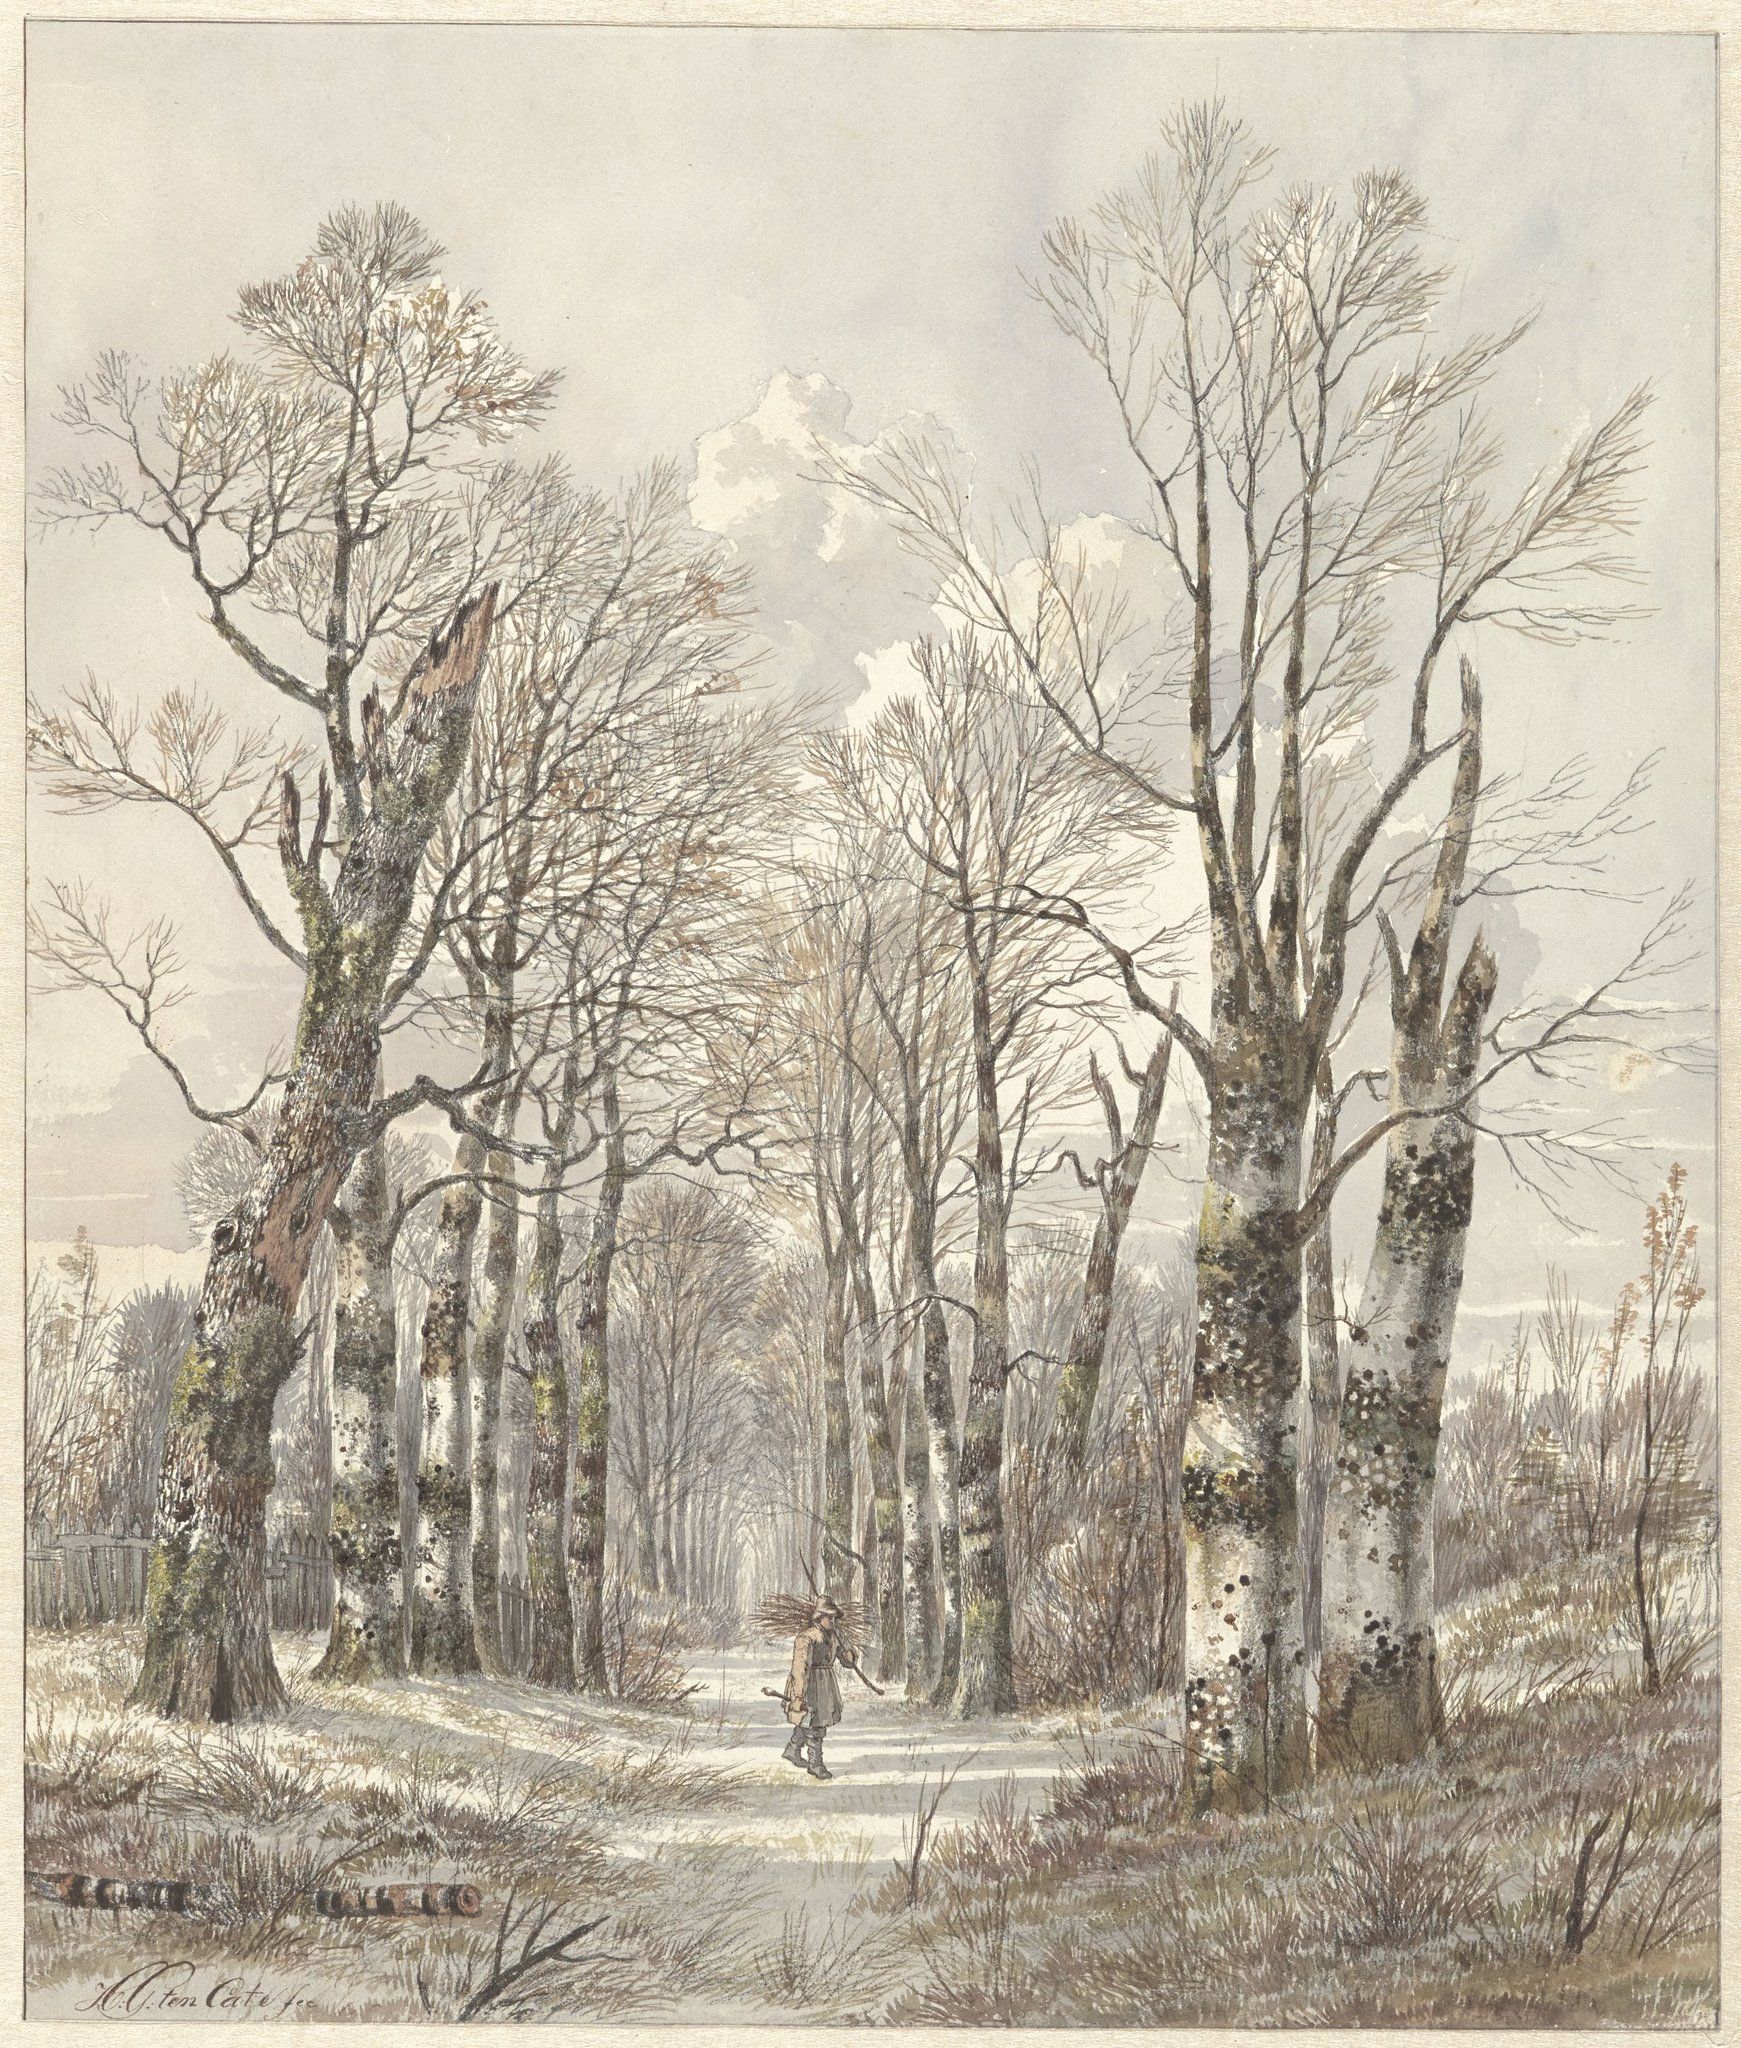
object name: watercolor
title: Winterlandschap met houtsprokkelaar op bospad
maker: hendrik gerrit ten cate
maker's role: draughtsman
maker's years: 1803-1856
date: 1813-1856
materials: chalk, ink, paper, watercolor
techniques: brush, pen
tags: forest, wood, ice ~ freezing weather